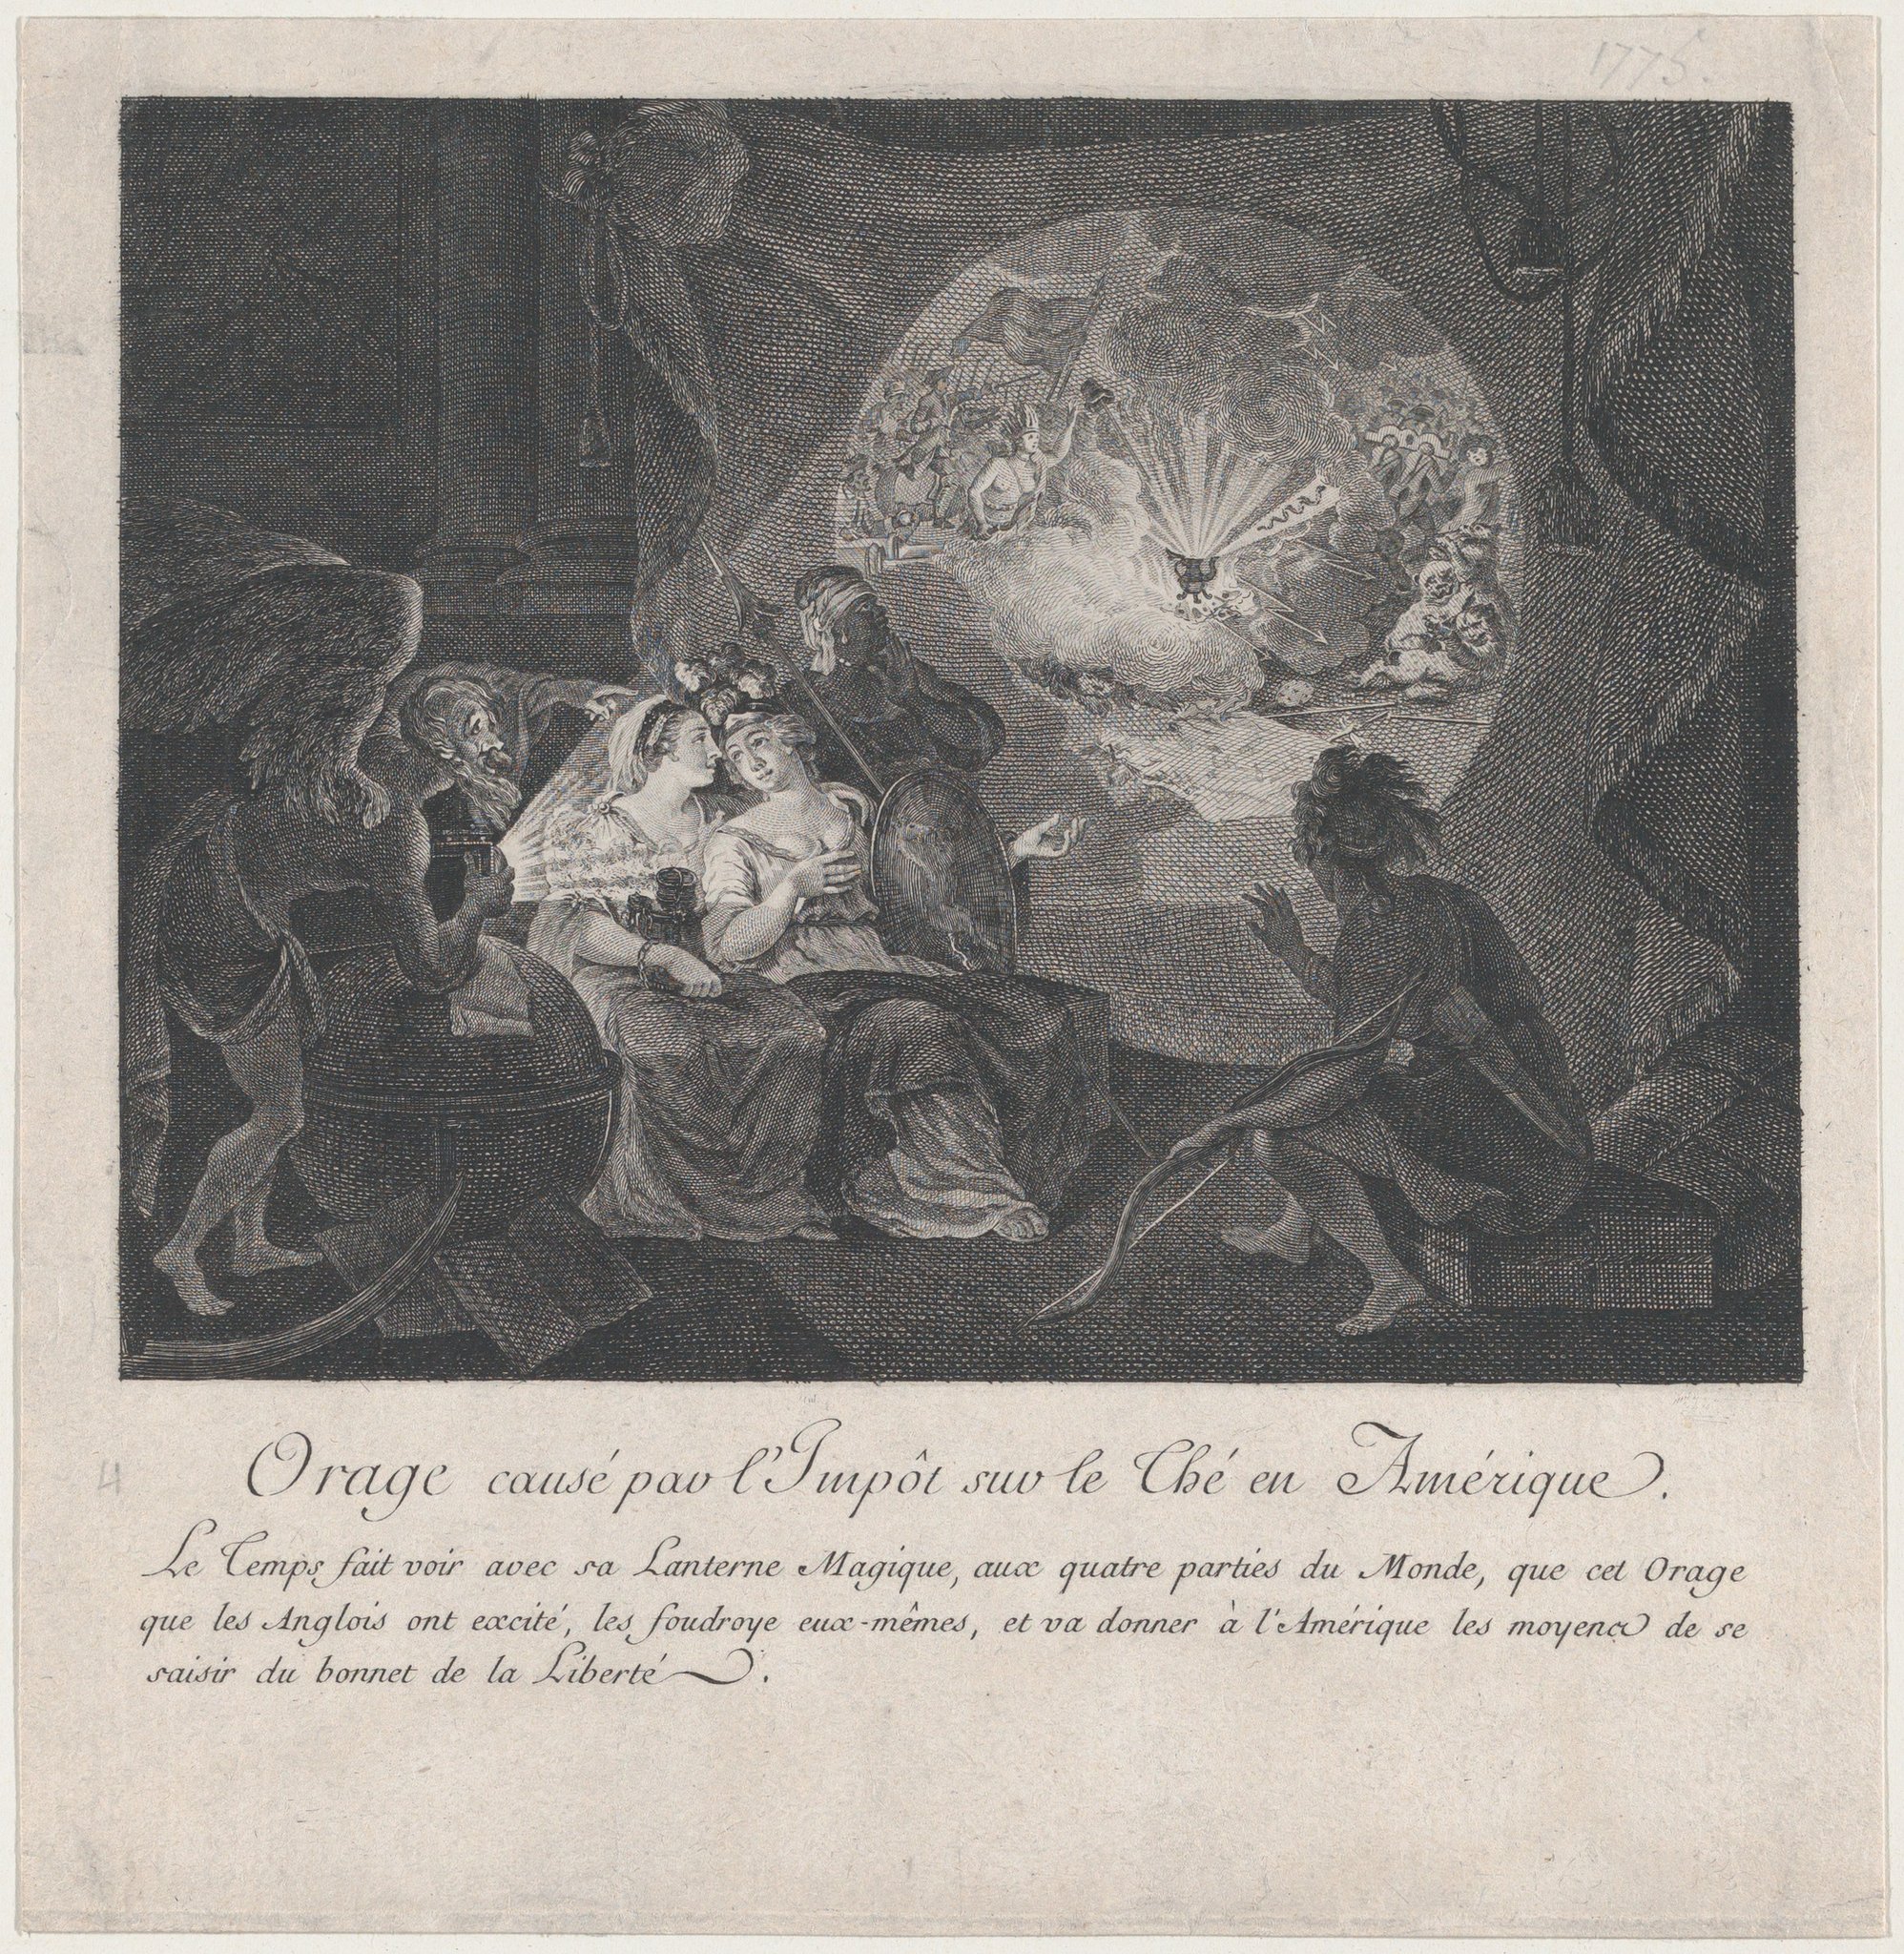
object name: print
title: Orage causé par l'Impôt sur le Thé en Amérique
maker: anonymous, french, 18th century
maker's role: engraver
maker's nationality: french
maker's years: 1700-1800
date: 1778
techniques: engraving, etching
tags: satire,american revolution,men,women,politics